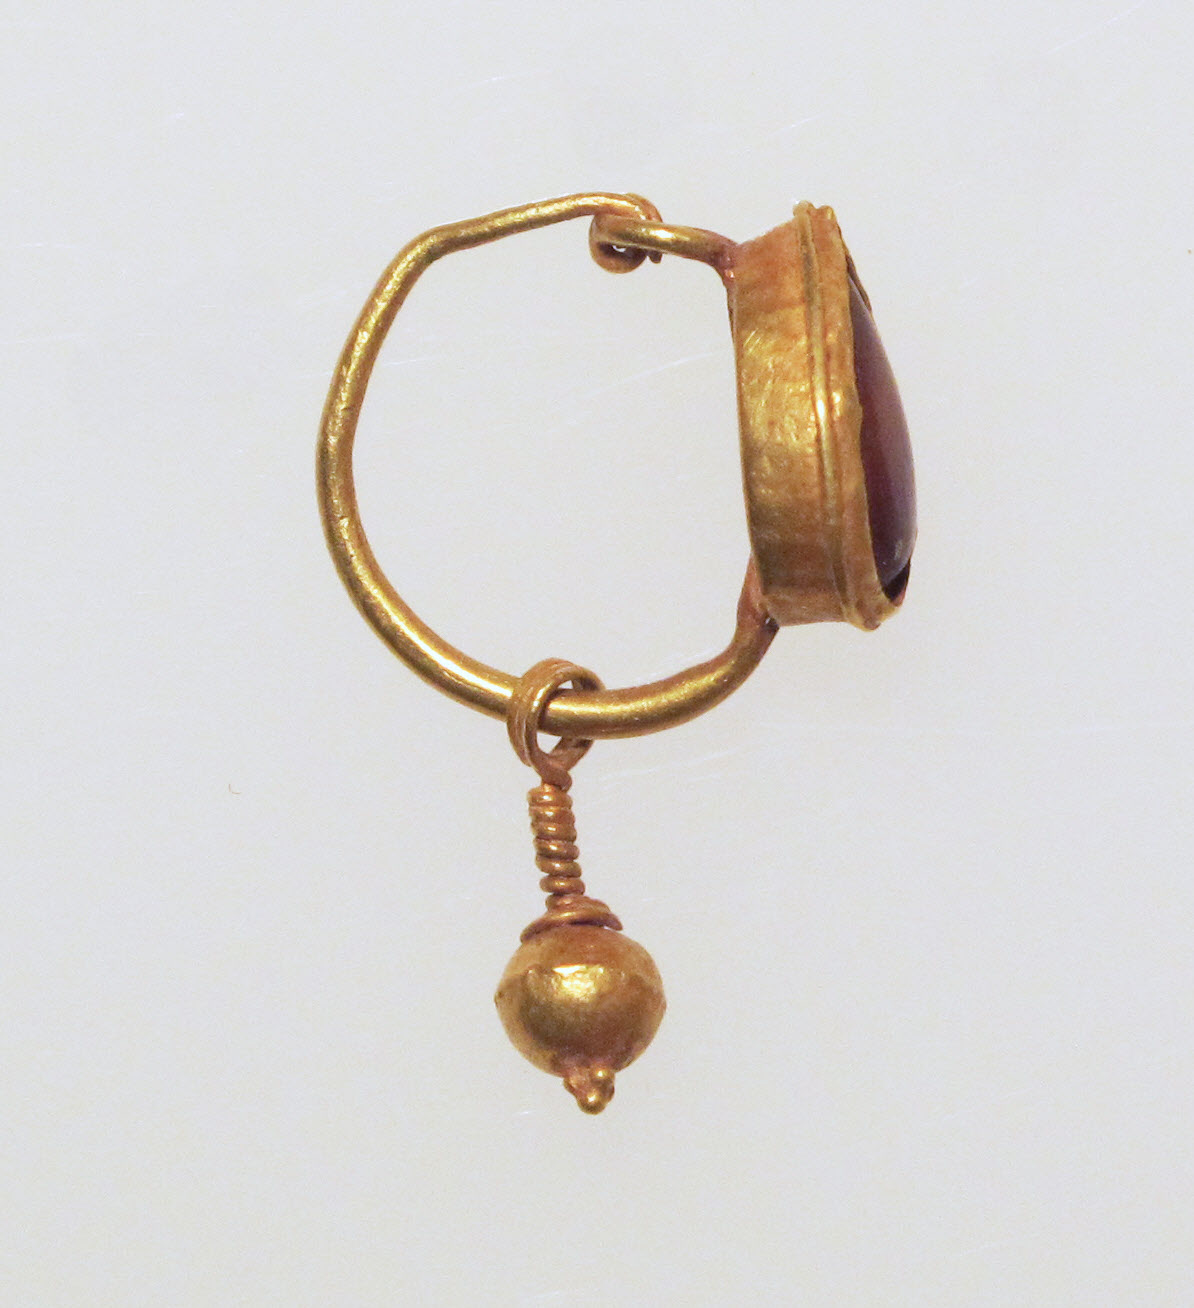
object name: earring with ball pendant and sard setting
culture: roman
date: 1-200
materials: gold